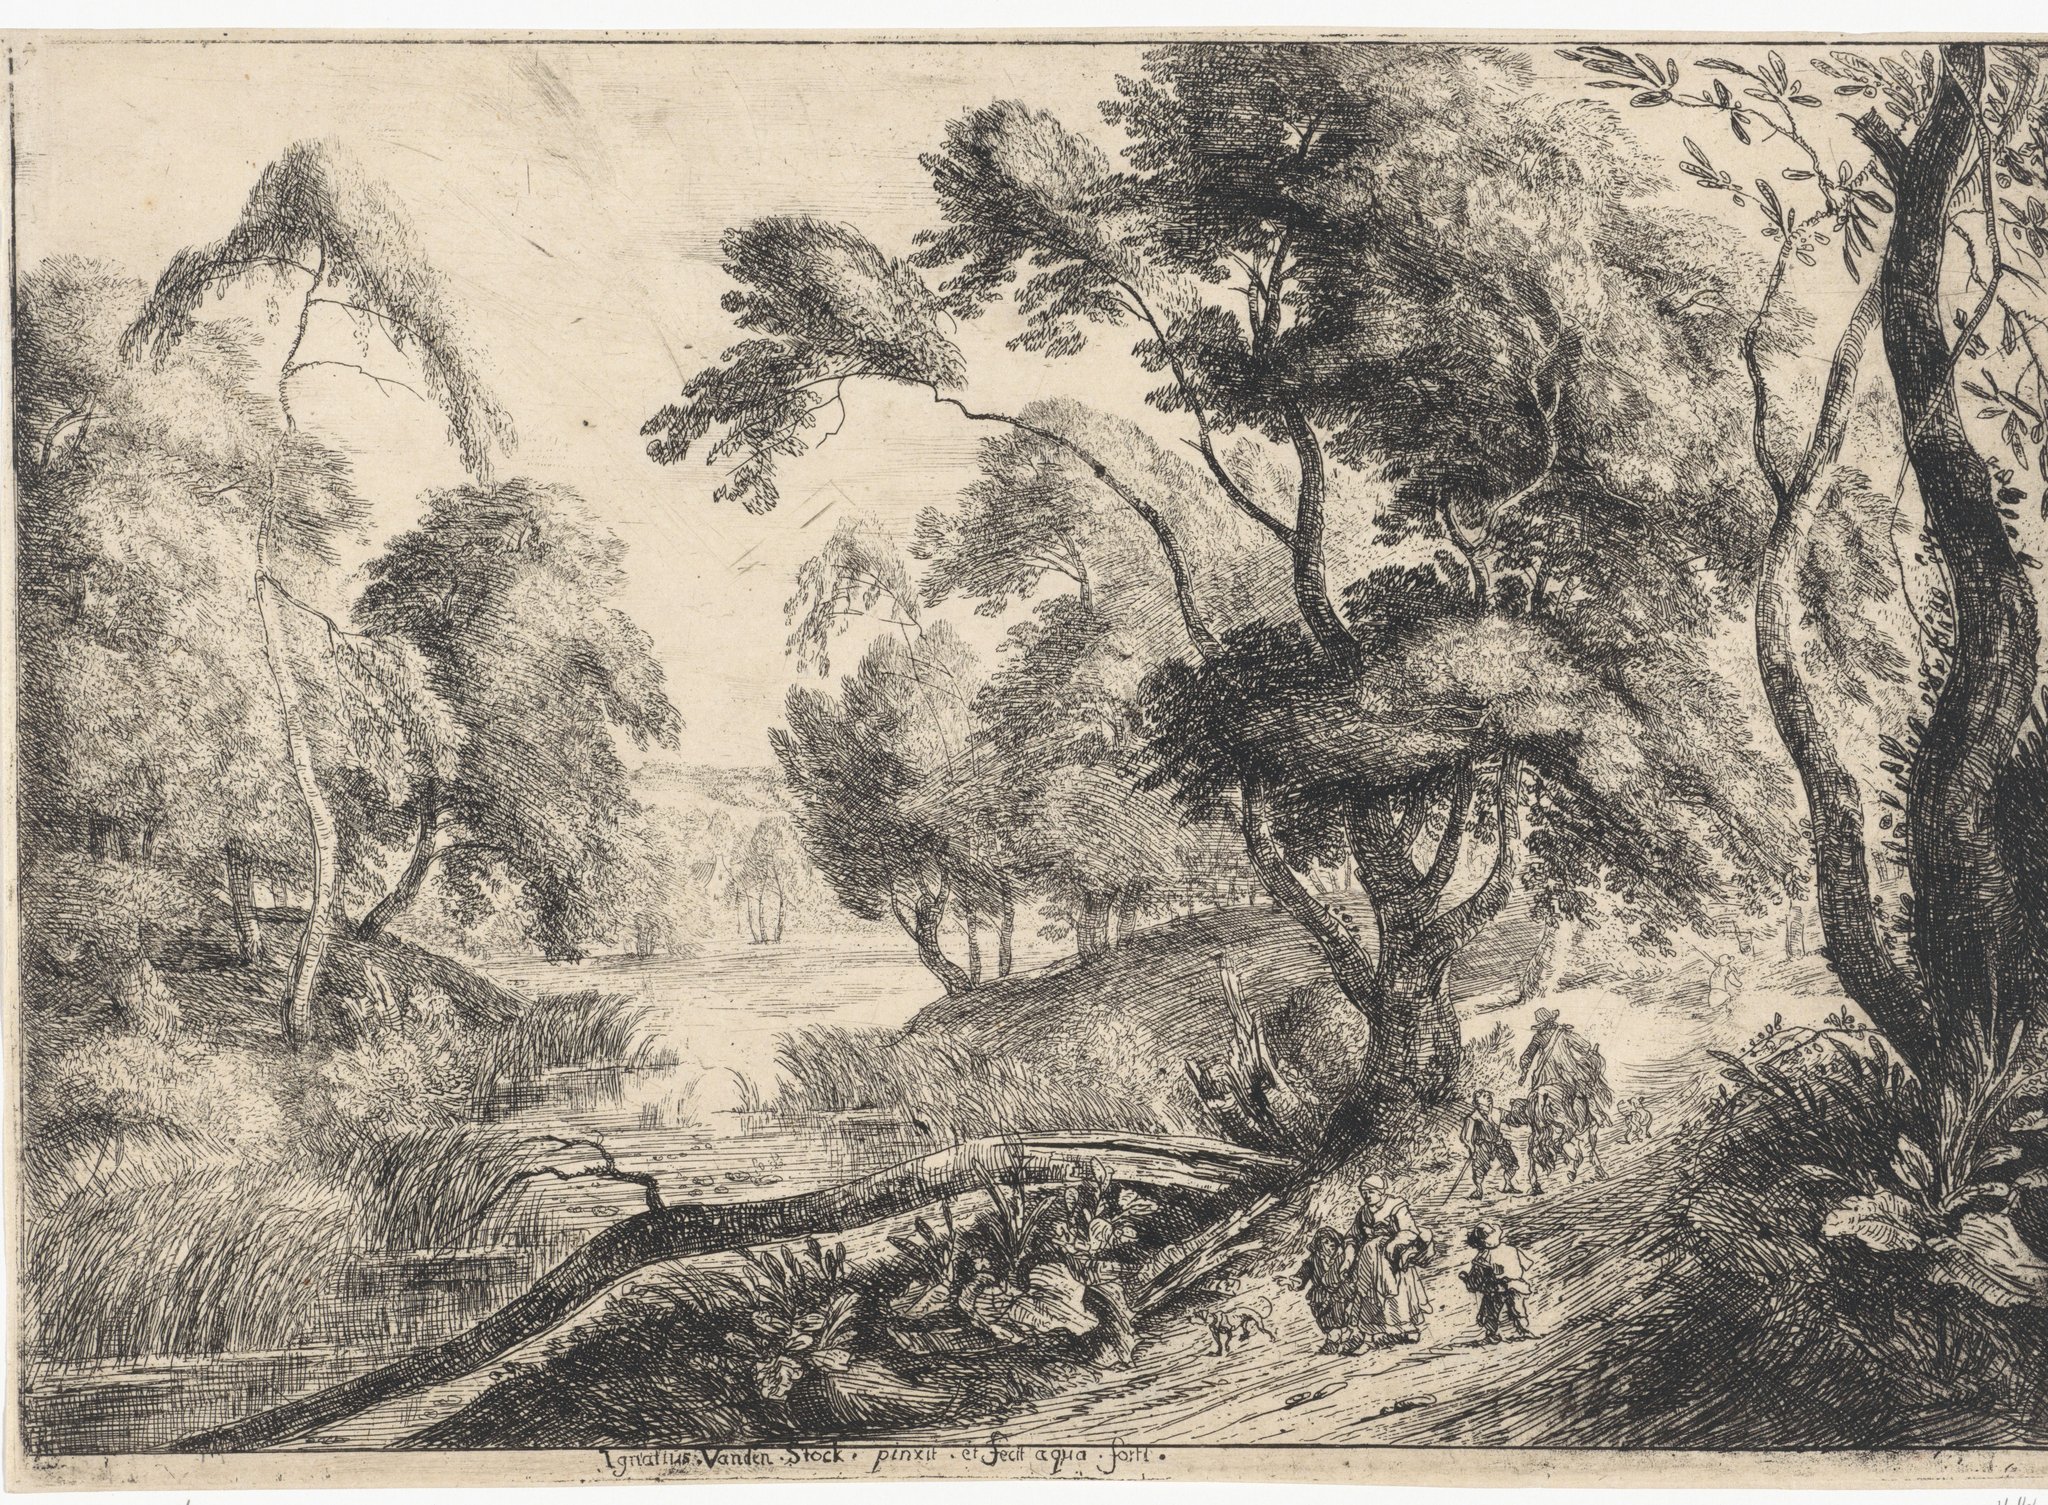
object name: print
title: Landschap met ruiter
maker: ignatius van der stock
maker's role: print maker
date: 1653-1665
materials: paper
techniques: etching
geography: brussels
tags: riding a horse, ass, or mule; rider, horseman, landscapes in the temperate zone, 'en route', traveller under way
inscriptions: collector's mark: Lugt 240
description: Landschap met water en geboomte. Rechts op de weg een ruiter en een man, die zijn hoed ophoudt. Meer op de voorgrond een vrouw met kinderen en een hond op weg.